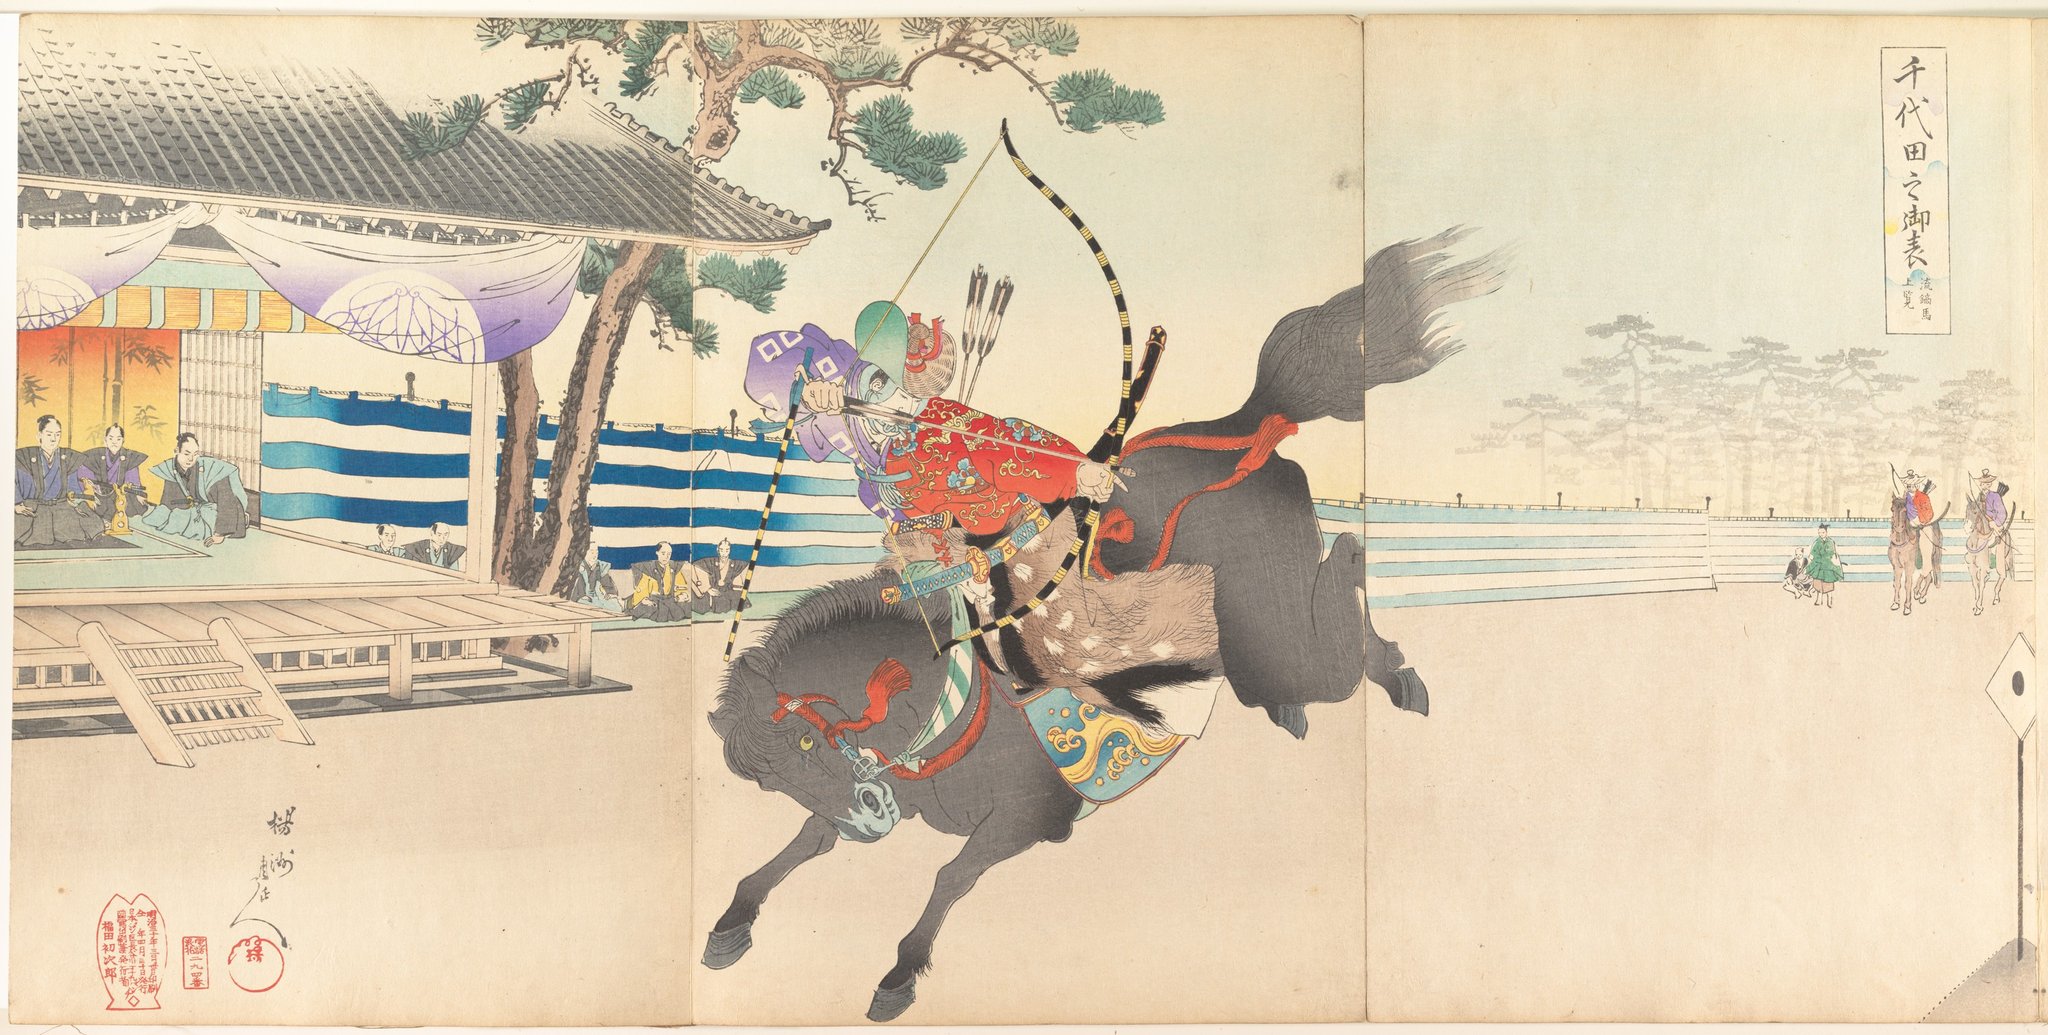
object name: print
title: Chiyoda Castle (Album of Men)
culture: japanese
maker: yōshū (hashimoto) chikanobu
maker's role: artist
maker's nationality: japanese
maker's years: 1838-1912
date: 1897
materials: ink, paper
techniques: woodblock print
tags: bow and arrow,men,horses,trees